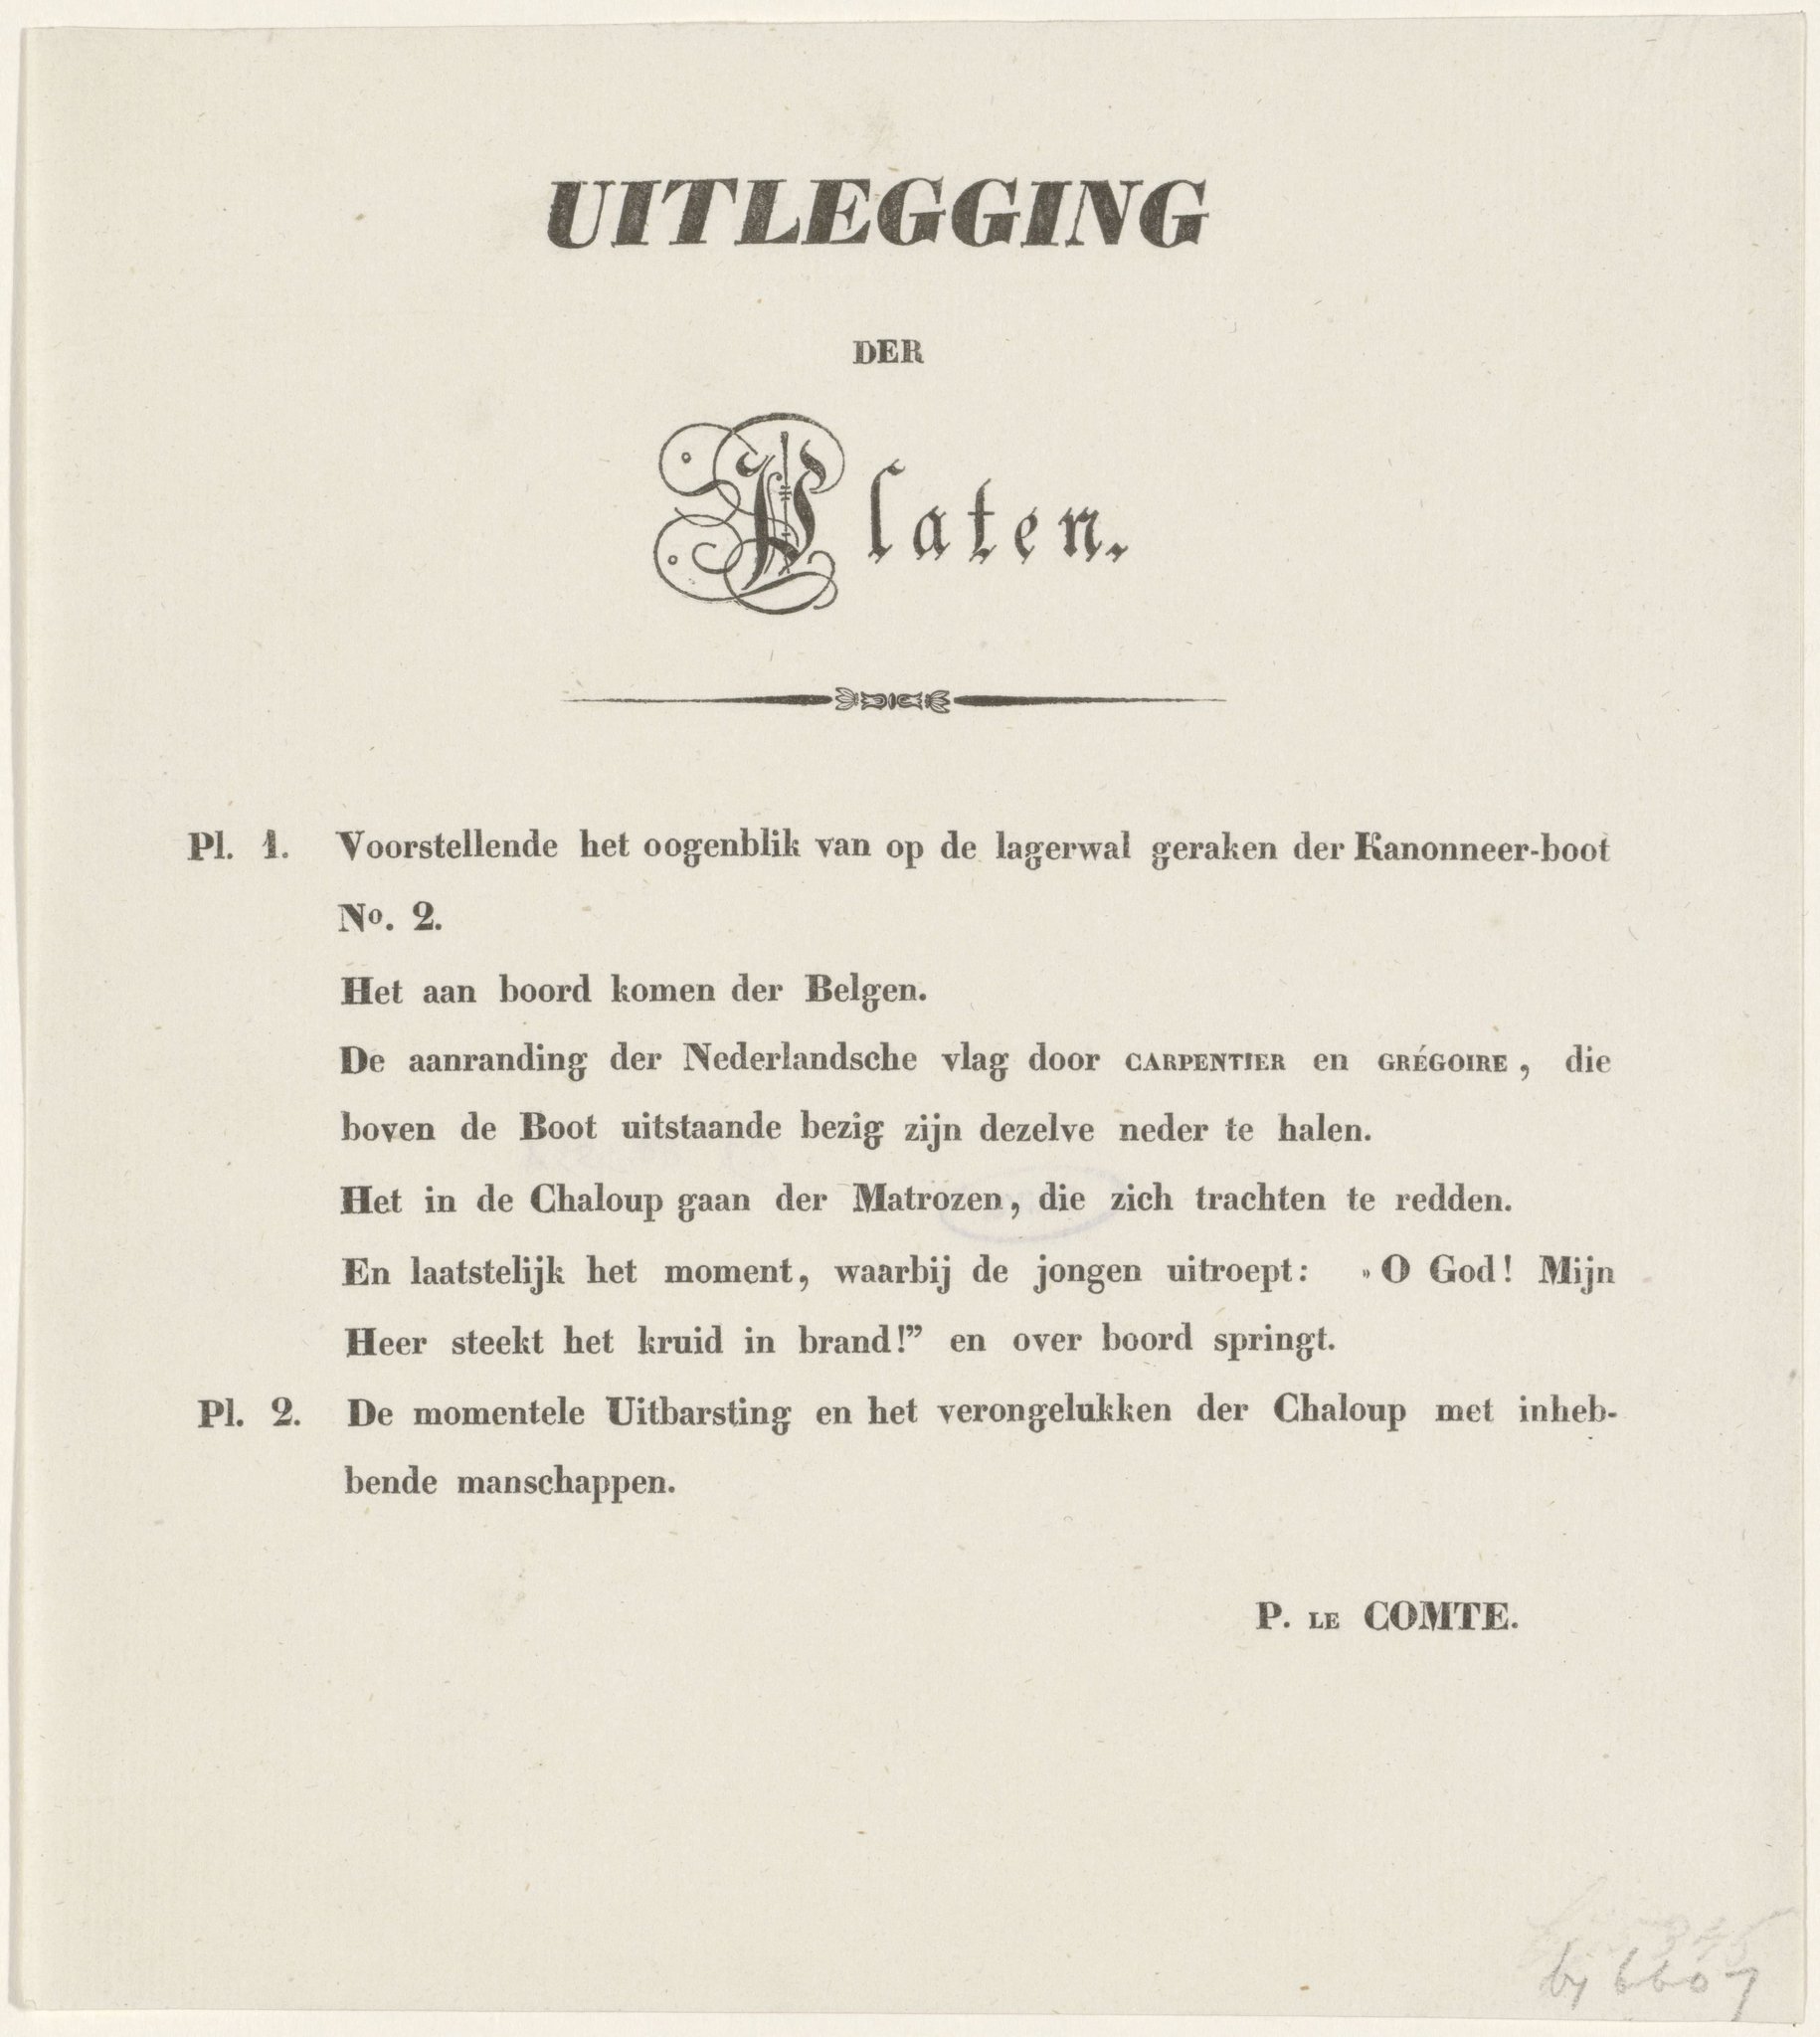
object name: text sheet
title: Uitlegging der Platen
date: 1831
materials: paper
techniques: letterpress printing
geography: amsterdam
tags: amsterdam, antwerp, jan van speyk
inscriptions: collector's mark: Lugt 2228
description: Tekstblad met de uitlegging van de voorstellingen van de twee platen over Jan van Speyk, 5 februari 1831.